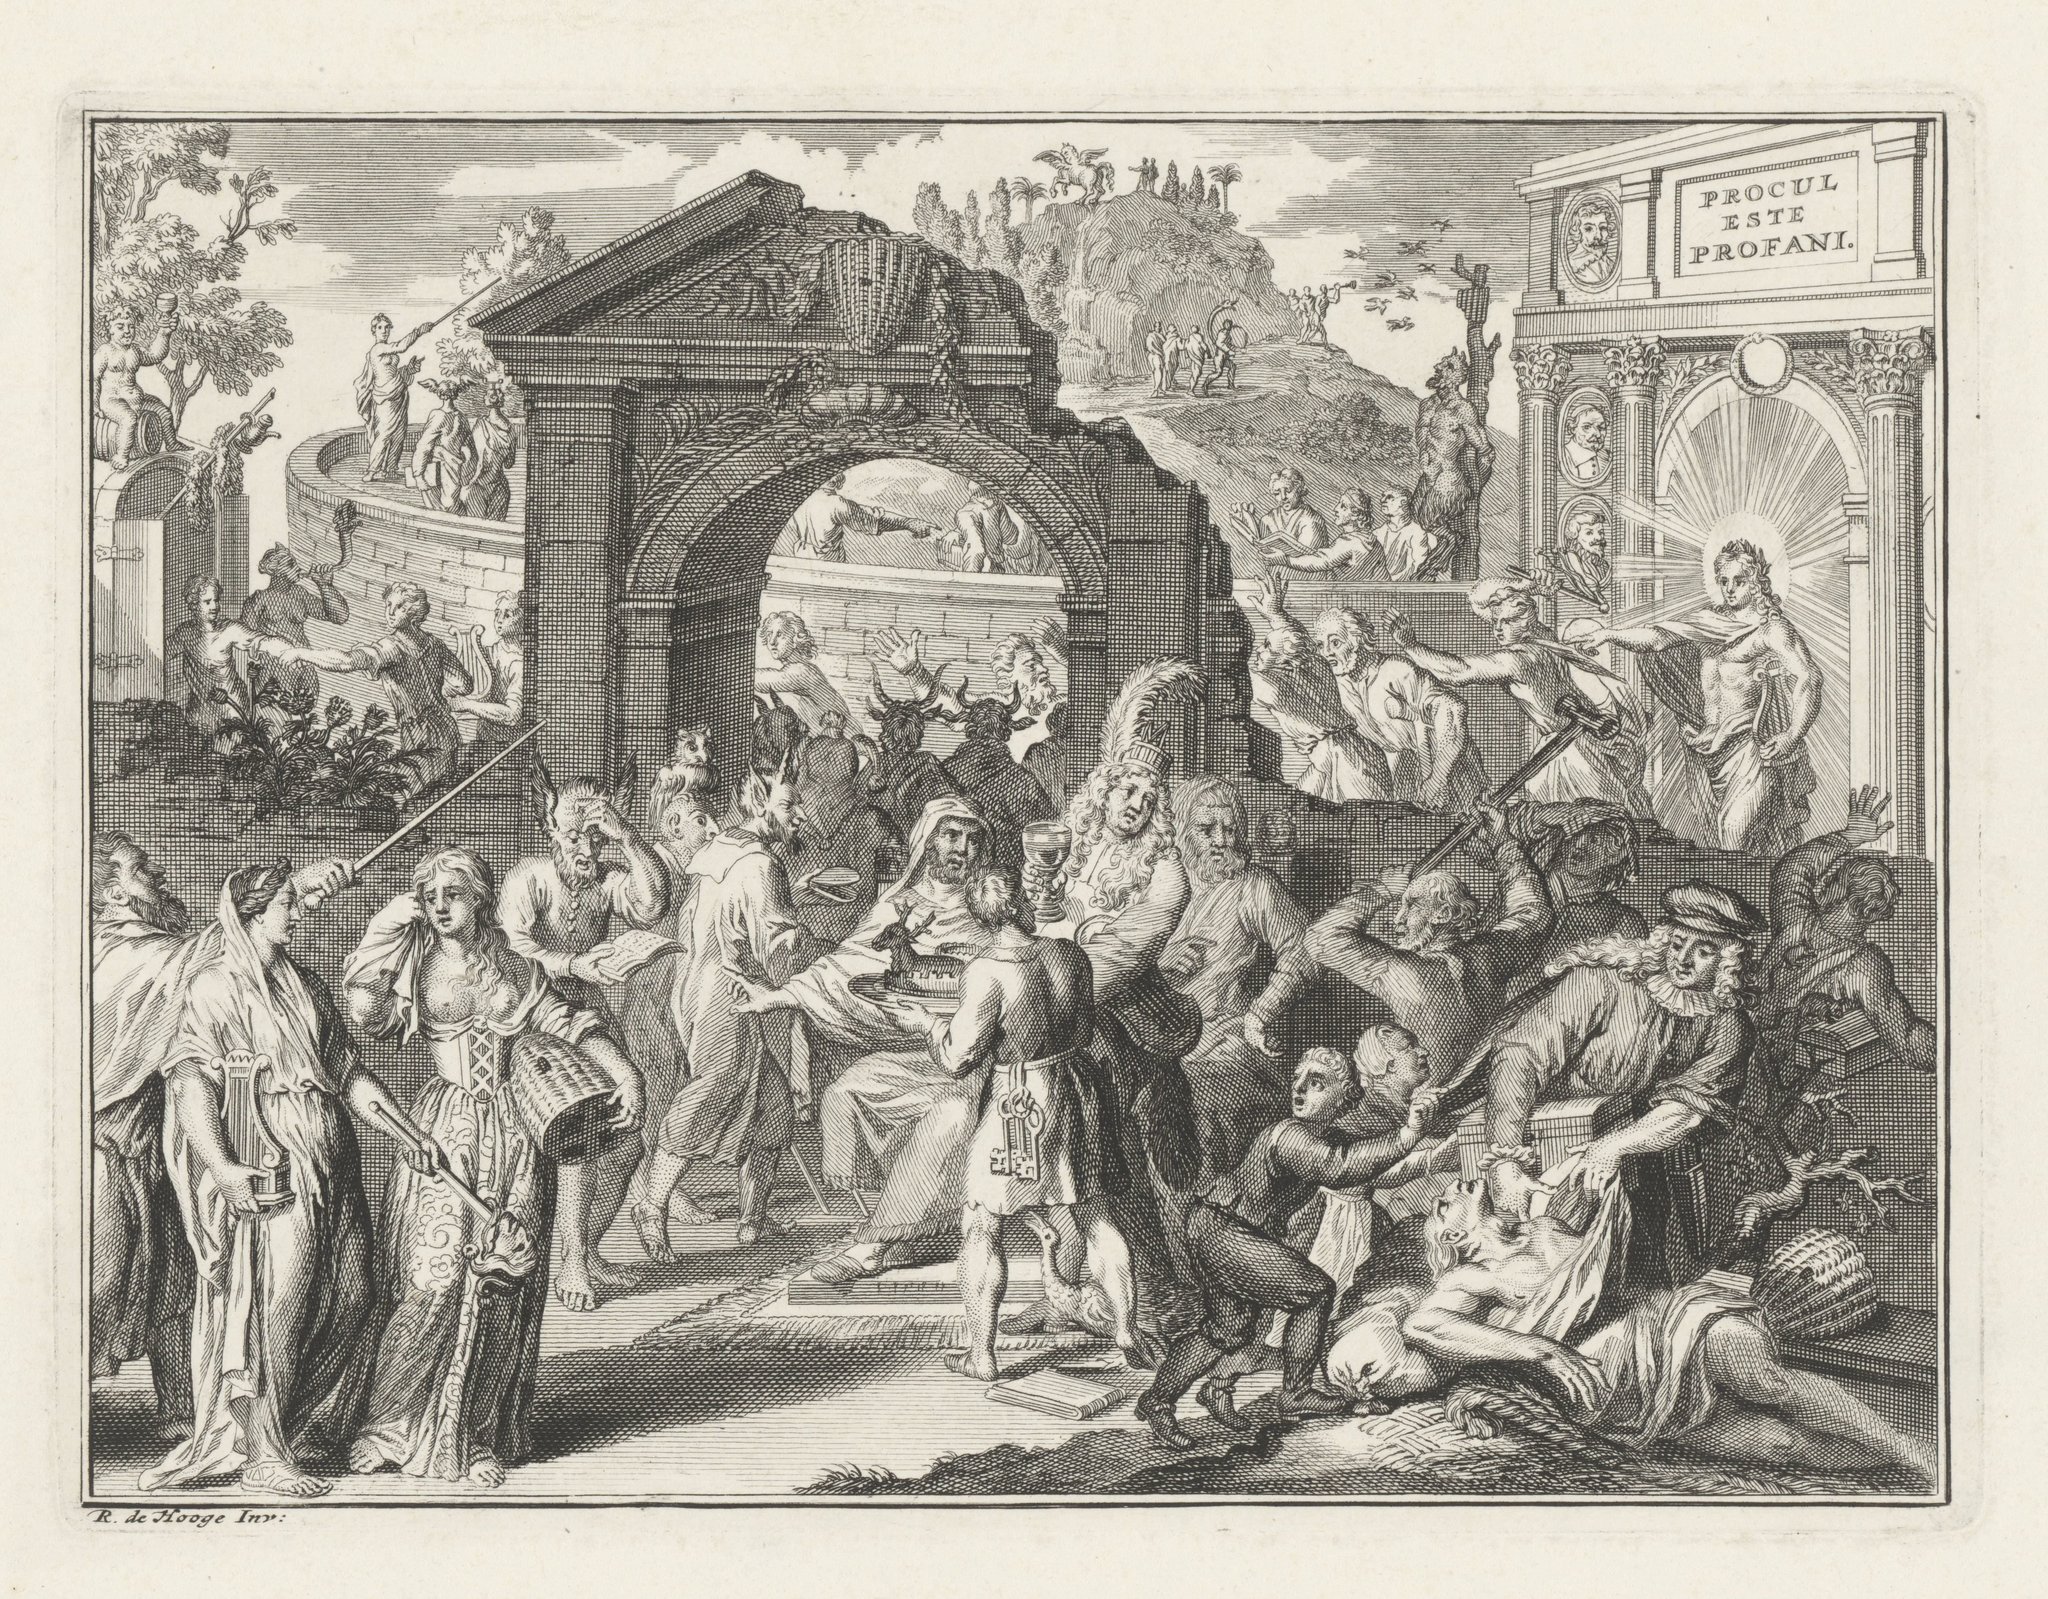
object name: cartoon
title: Spotprent op de Schouwburgstrijd, ca. 1685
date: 1716-1738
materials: paper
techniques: engraving, etching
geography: amsterdam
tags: the hague, pieter corneliszoon hooft, govard bidloo, cologne, joost van den vondel, joan pluimer, amsterdam, gerbrand adriaensz. bredero, attributes of apollo: lyre, pegasus, the winged horse, symbolic representations, allegories and emblems ~ the theatre, (story of) apollo (phoebus), bee-hive, (story of) marsyas, melpomene (one of the muses); 'melpomene' (ripa)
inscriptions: collector's mark: Lugt 2228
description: Spotprent op het wanbeheer van Joan Pluimer en Govert Bidloo, die van 1679 tot 1681 regenten, en van 1681 tot 1687 pachters van de Amsterdamse Schouwburg waren. In het midden staat Pluimer met een veer op zijn hoofd, een bokaal drank in zijn hand en een lier onder zijn arm. Voor hem een dienaar met een pastei in de vorm van een hert. Rechts van hem een grijsaard die een stok richting hem heft. Links op de voorgrond een bedroefde personificatie van de Amsterdamse Schouwburg met een bijenkorf in haar hand, links van haar de muze Melpomene. Rechts op de voorgrond wordt een overleden man (mogelijk de in 1687 overleden medepachter Pieter de la Croix) van zijn lijkkleed beroofd door een man met een baret op zijn hoofd en een geldkoffer onder zijn arm (waarschijnlijk Bidloo). Publiek met ezelsoren op loopt door de vervallen boog naar het theater maar wordt door Apollo verjaagd. Apollo staat voor een poort met daarop links, van boven naar beneden, de portretten van Pieter Corneliszoon Hooft, Joost van den Vondel en Gerbrand Adriaensz. Bredero. Daarachter de sater Marsyas vastgebonden aan een boom. Helemaal op de achtergrond Pegasus op de berg Parnassus.